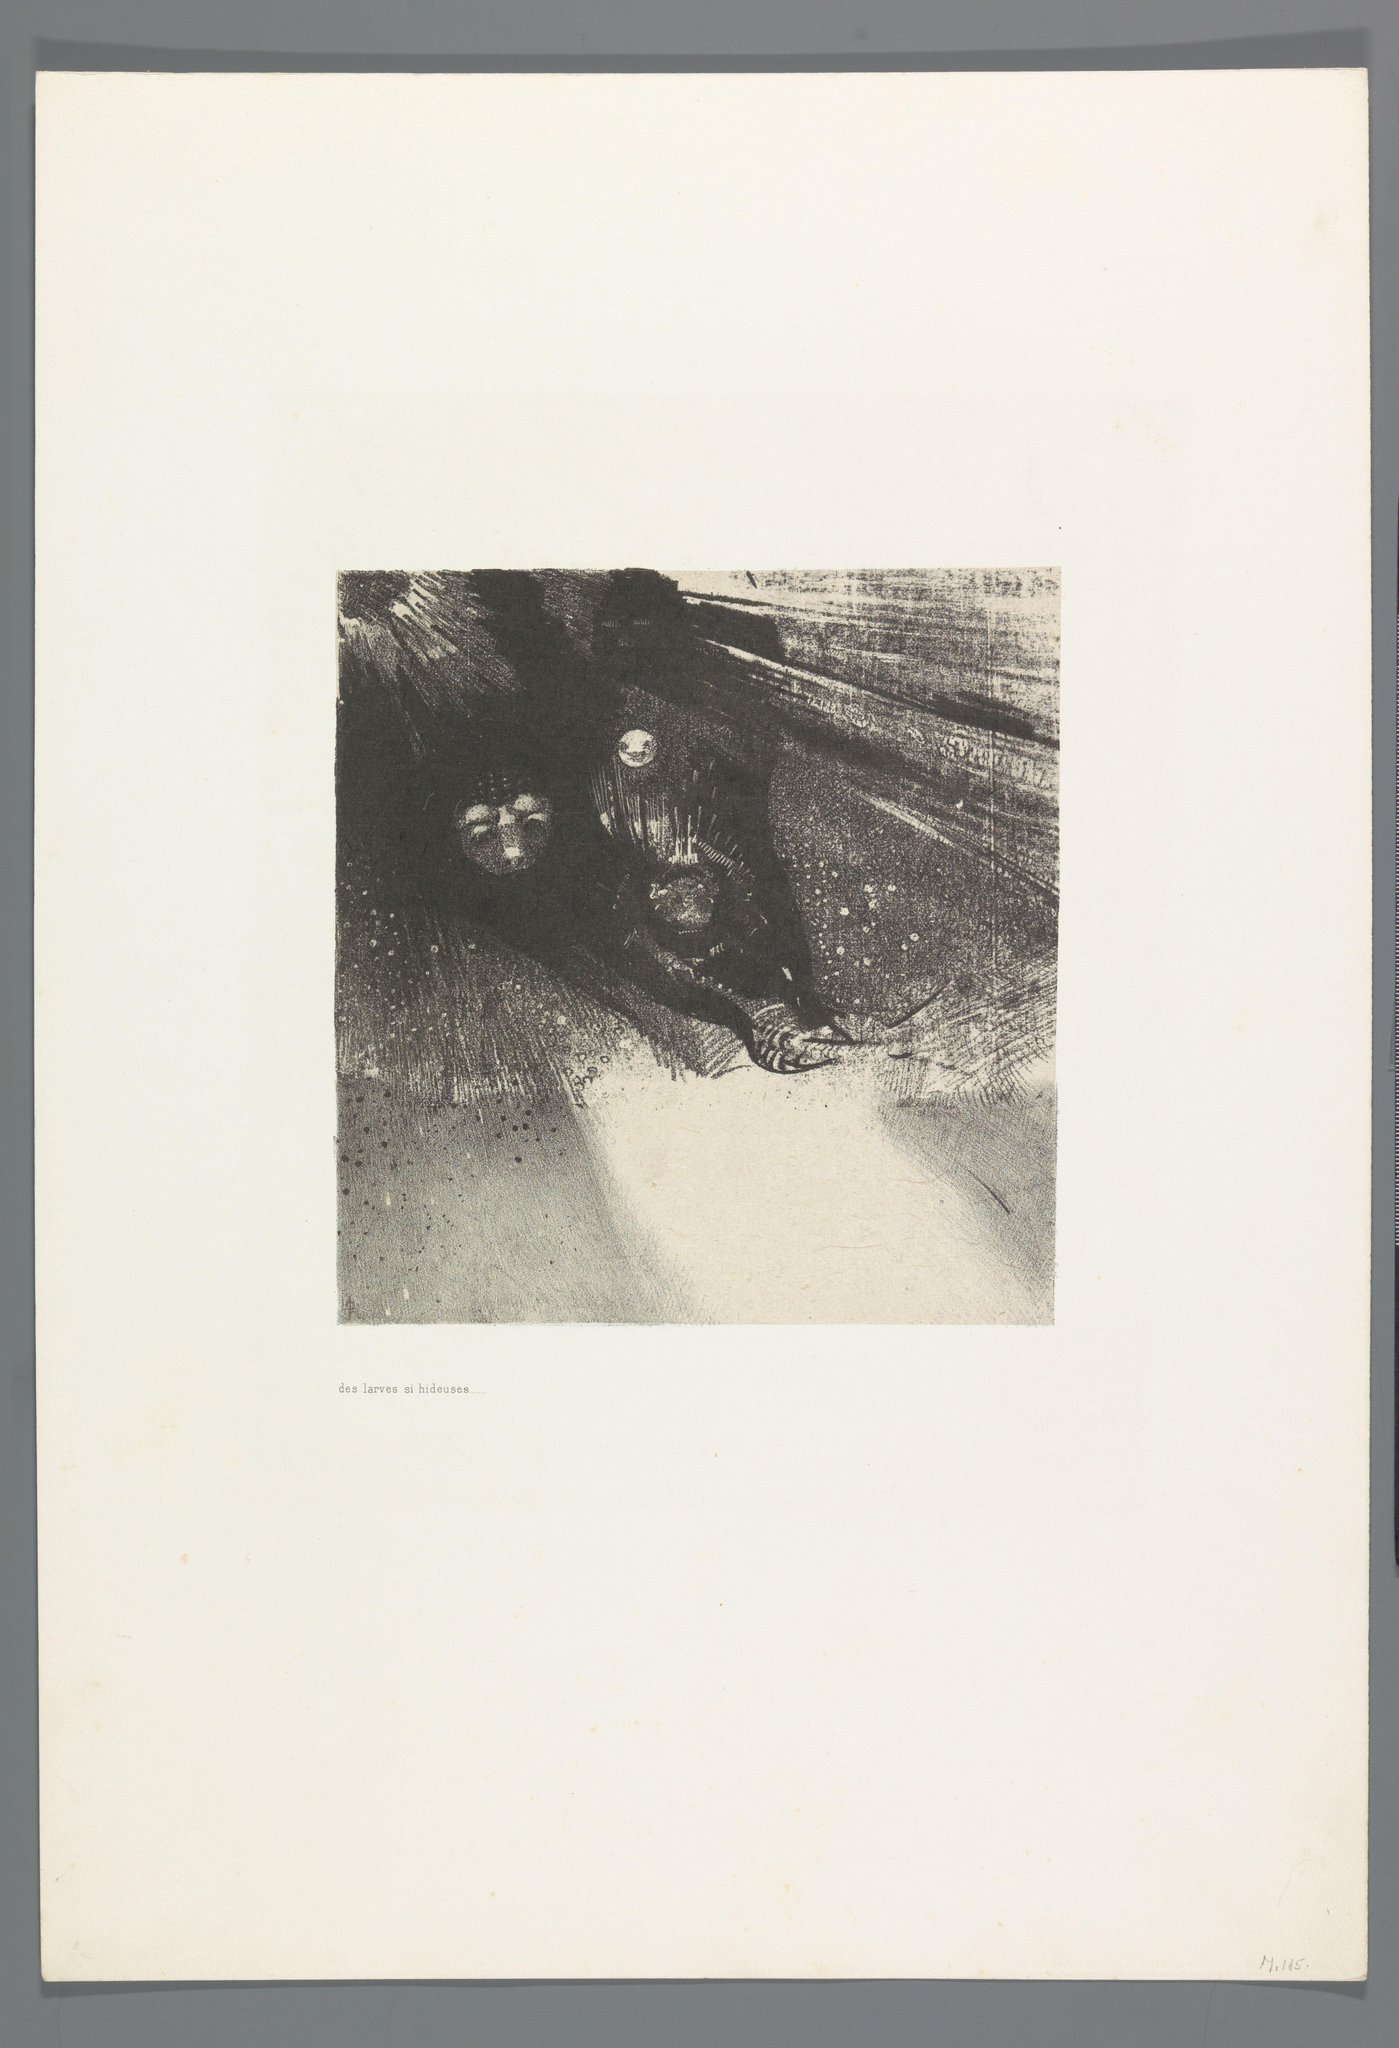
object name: print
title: La Maison Hautée, 6 litho's omslag titelblad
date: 1896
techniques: printmaking, lithograph